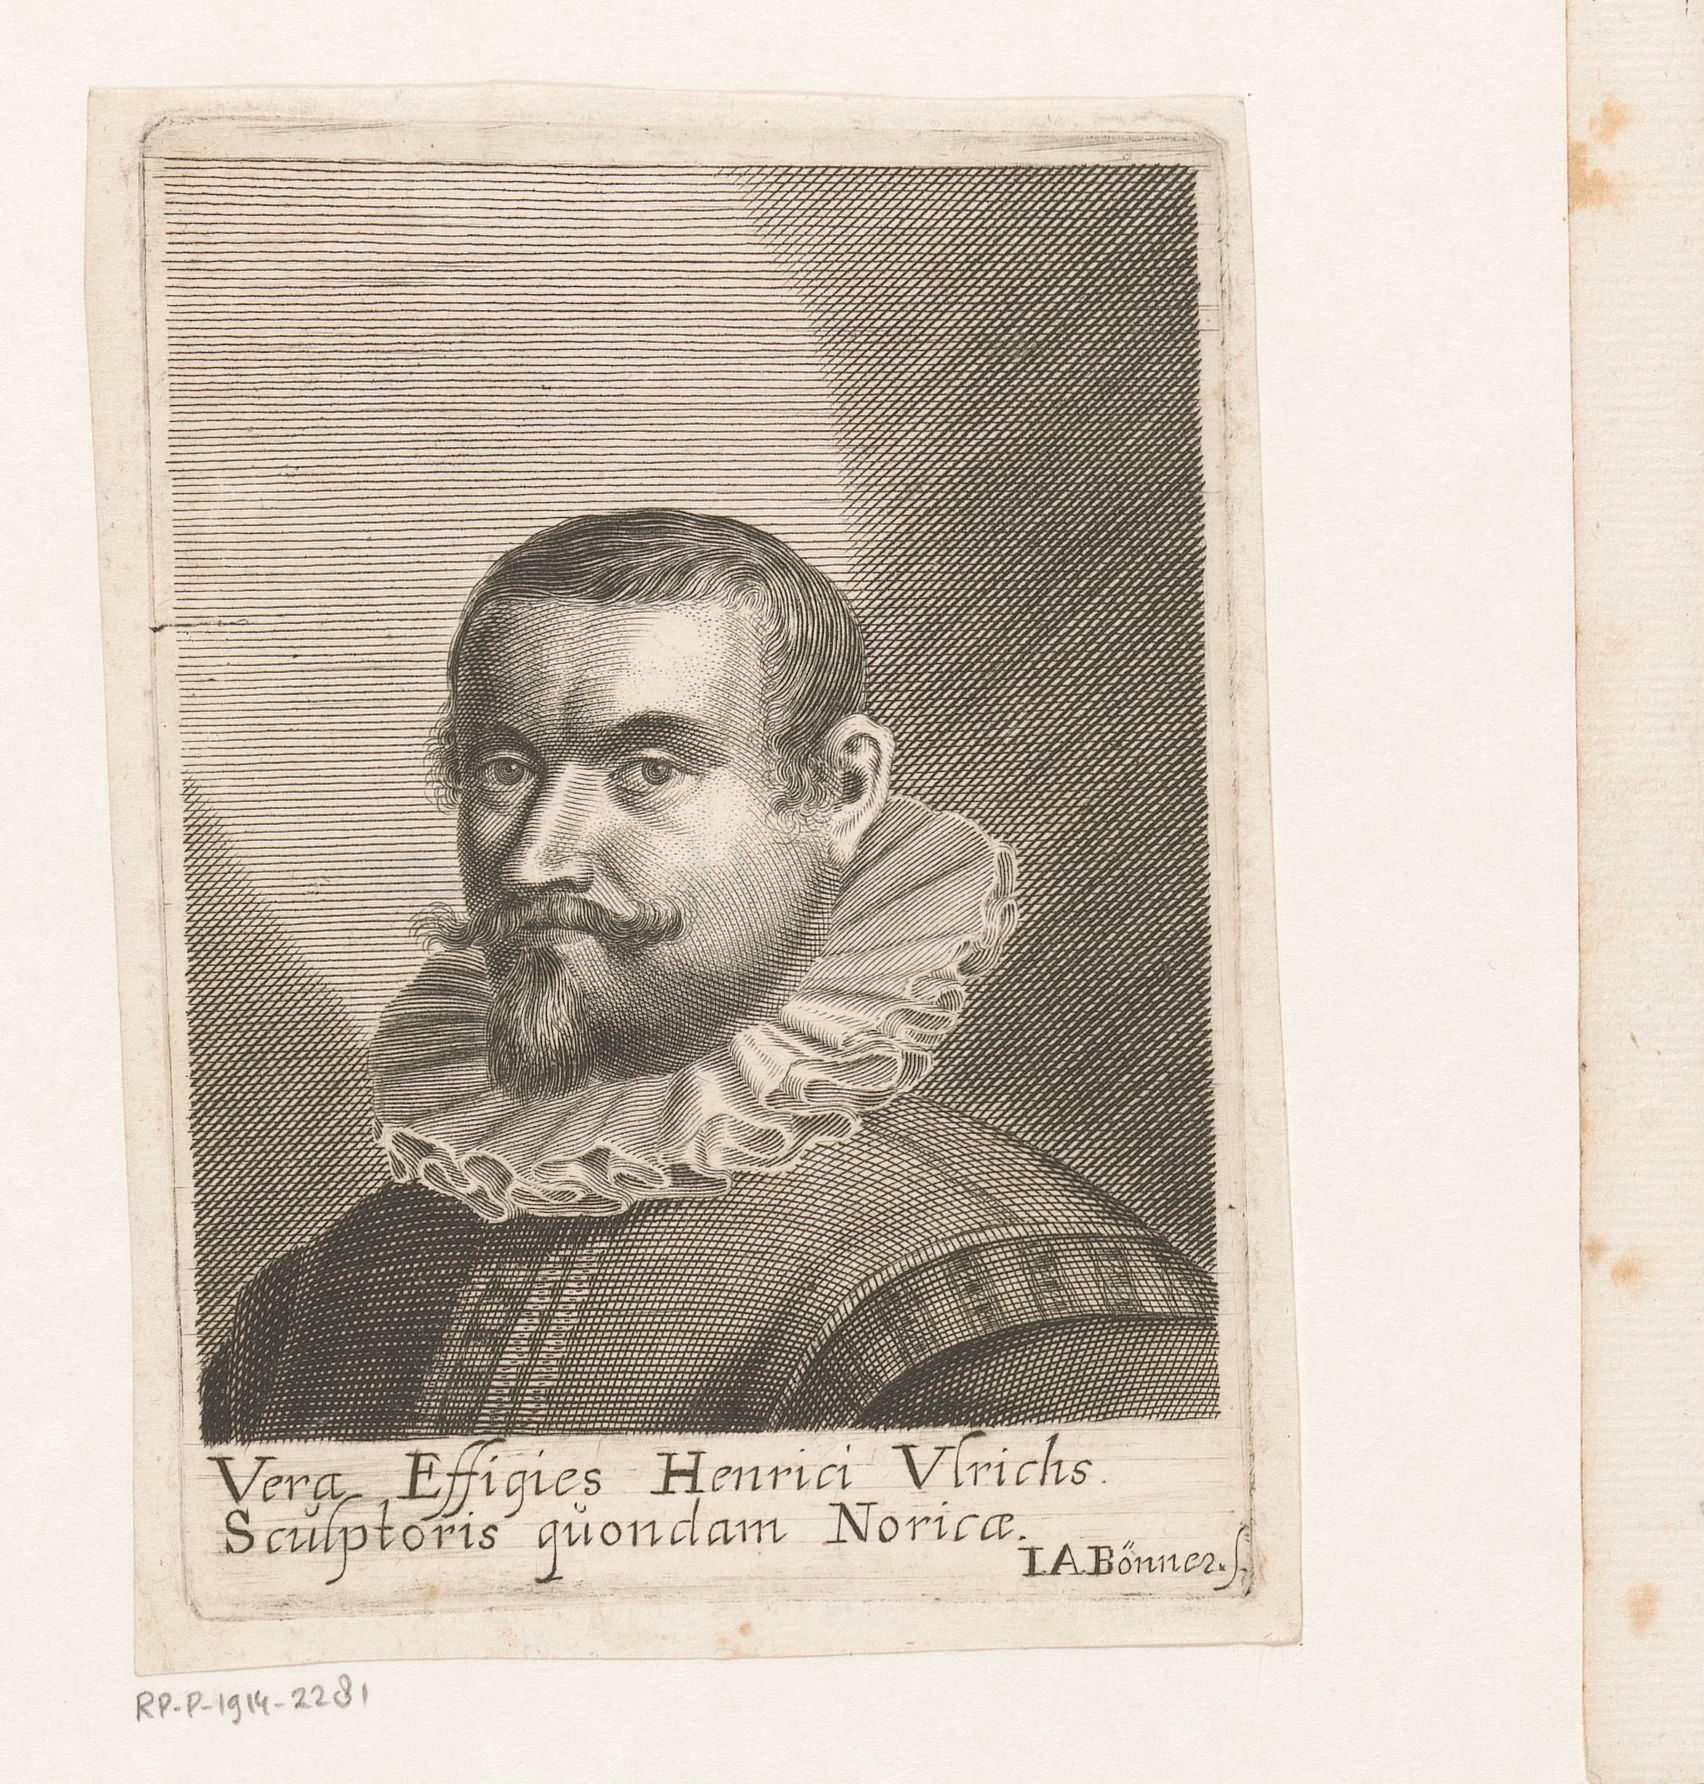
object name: print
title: Portret van Heinrich Ulrich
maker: johann alexander böner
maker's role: draughtsman, print maker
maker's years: 1647-1720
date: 1657-1720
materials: paper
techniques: engraving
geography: nuremberg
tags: painter, print maker, draughtsman, heinrich ulrich, historical persons, portrait, self-portrait of graphic artist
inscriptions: collector's mark: Lugt 2228